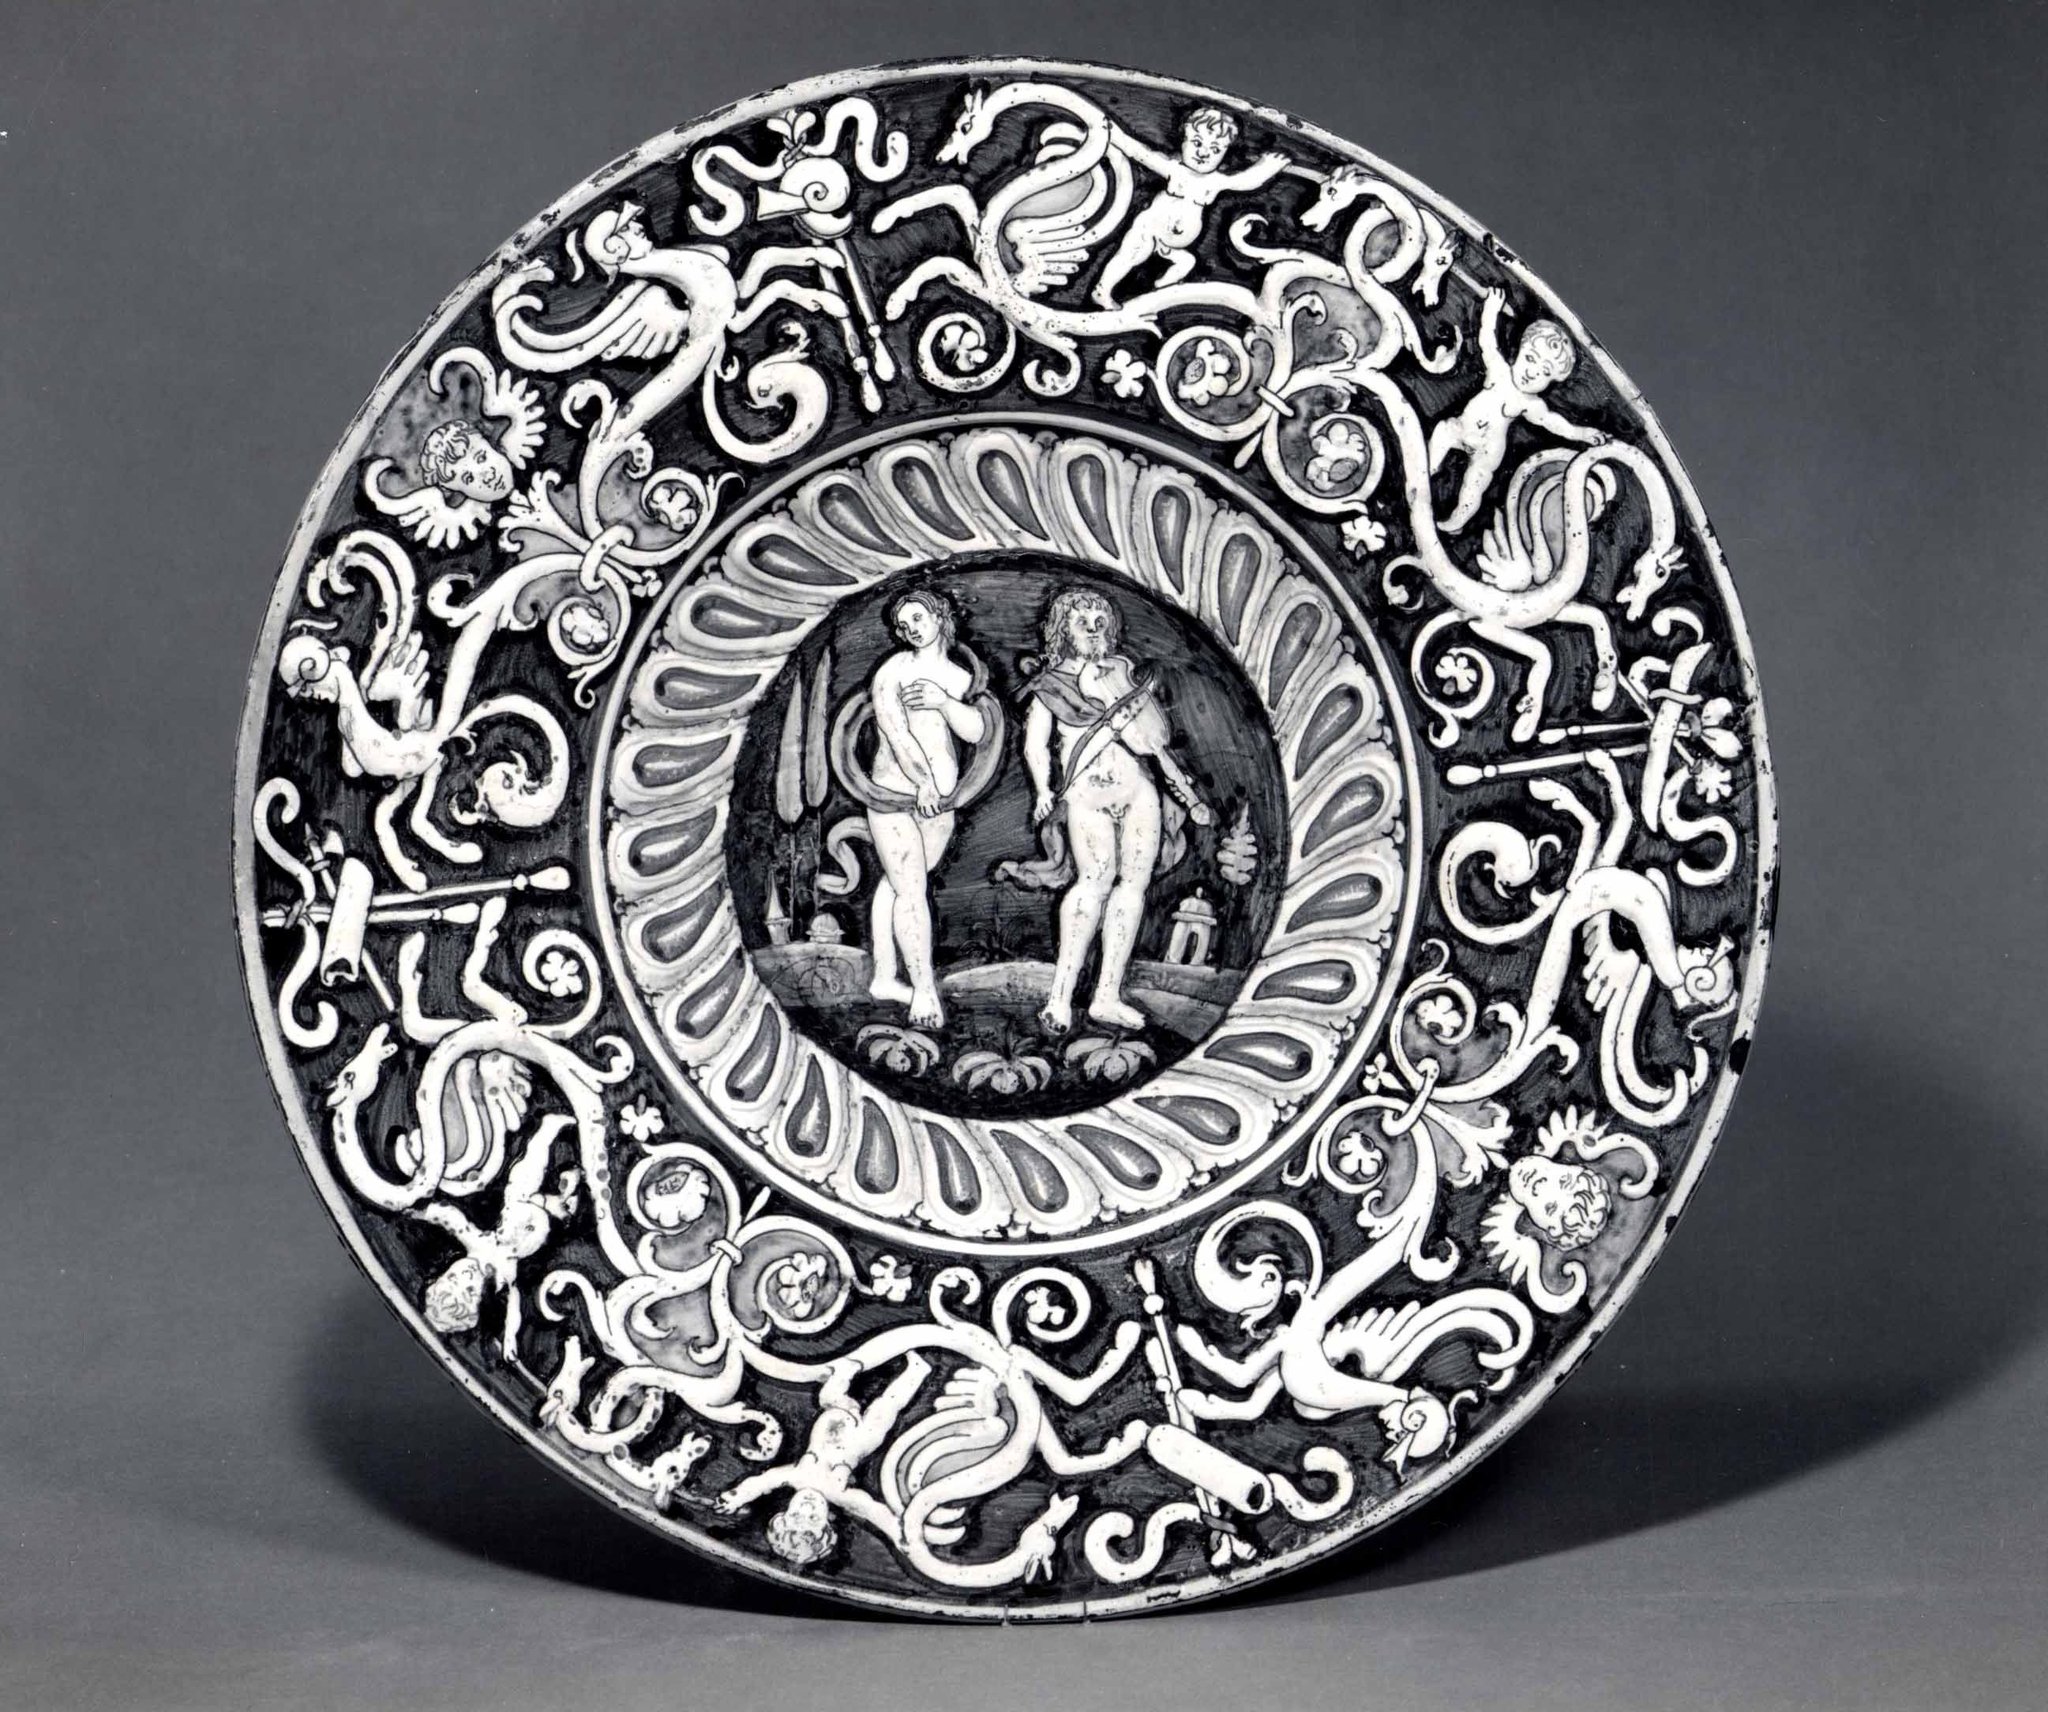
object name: plate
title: Plate (tagliere)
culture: italian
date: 1530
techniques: maiolica, glazing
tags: musical instruments,male nudes,female nudes,orpheus,eurydice